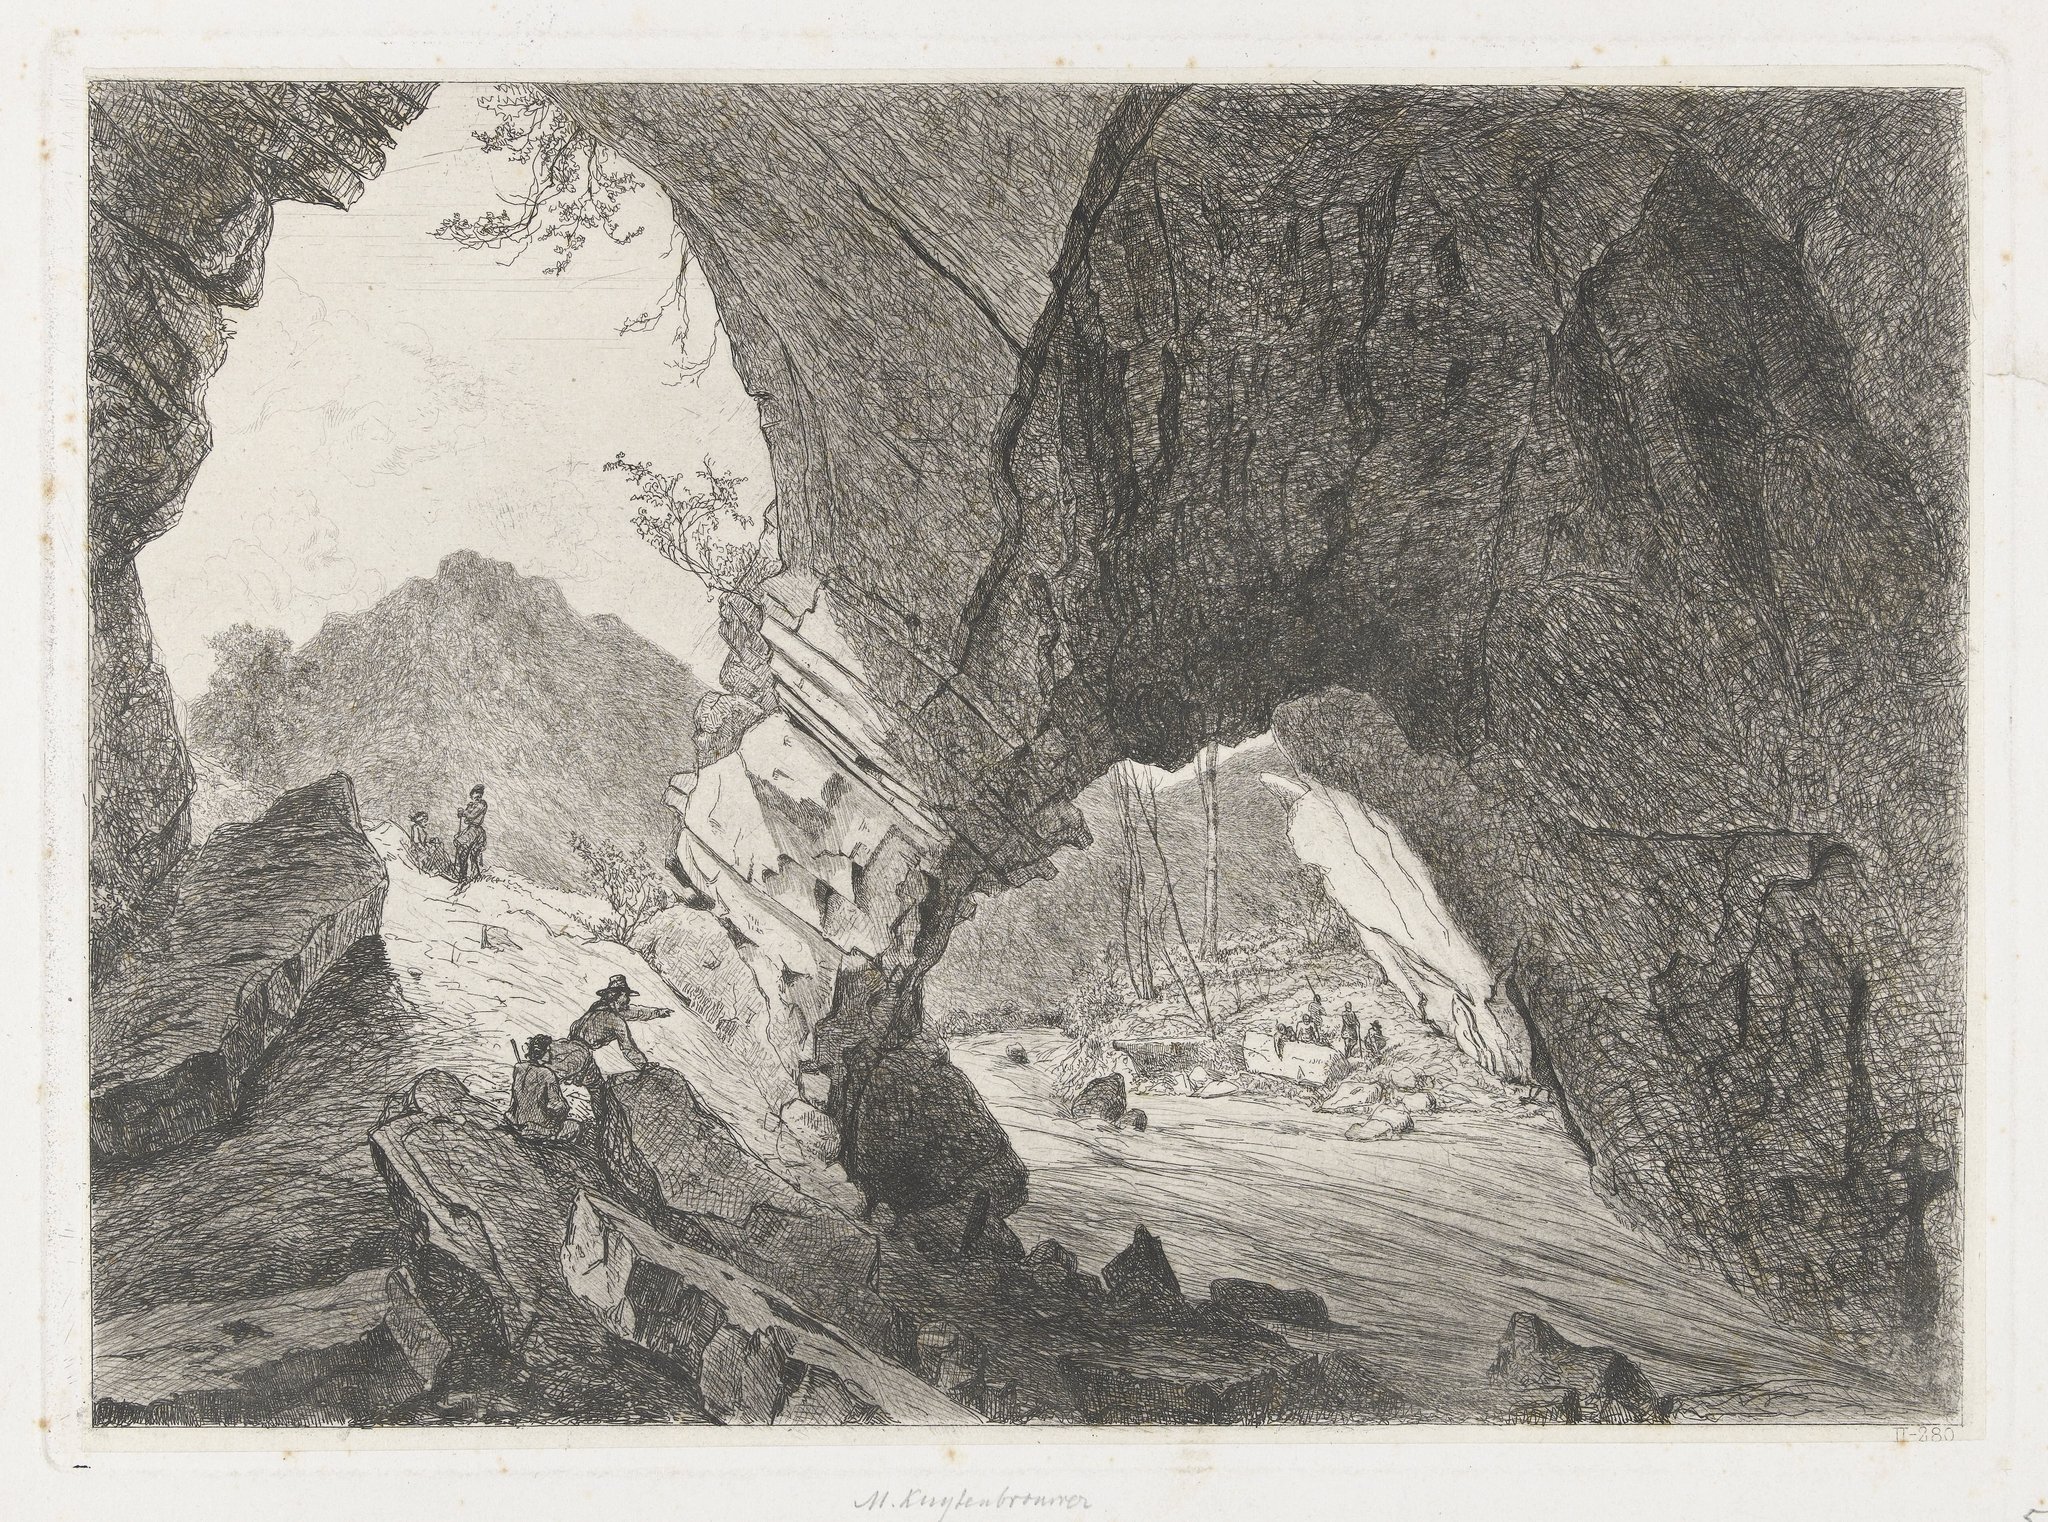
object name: print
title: Uitgang van de grotten van Han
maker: martinus antonius kuytenbrouwer jr.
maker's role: draughtsman, painter, print maker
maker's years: 1821-1897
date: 1853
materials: paper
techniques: drypoint, etching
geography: brussels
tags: cave, grotto, 'en route', traveller under way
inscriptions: collector's mark: Lugt 2228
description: Uitgang van de grotten van Han en de rivier de Lesse. Op de voorgrond twee reizigers en op de achtergrond enkele figuren.